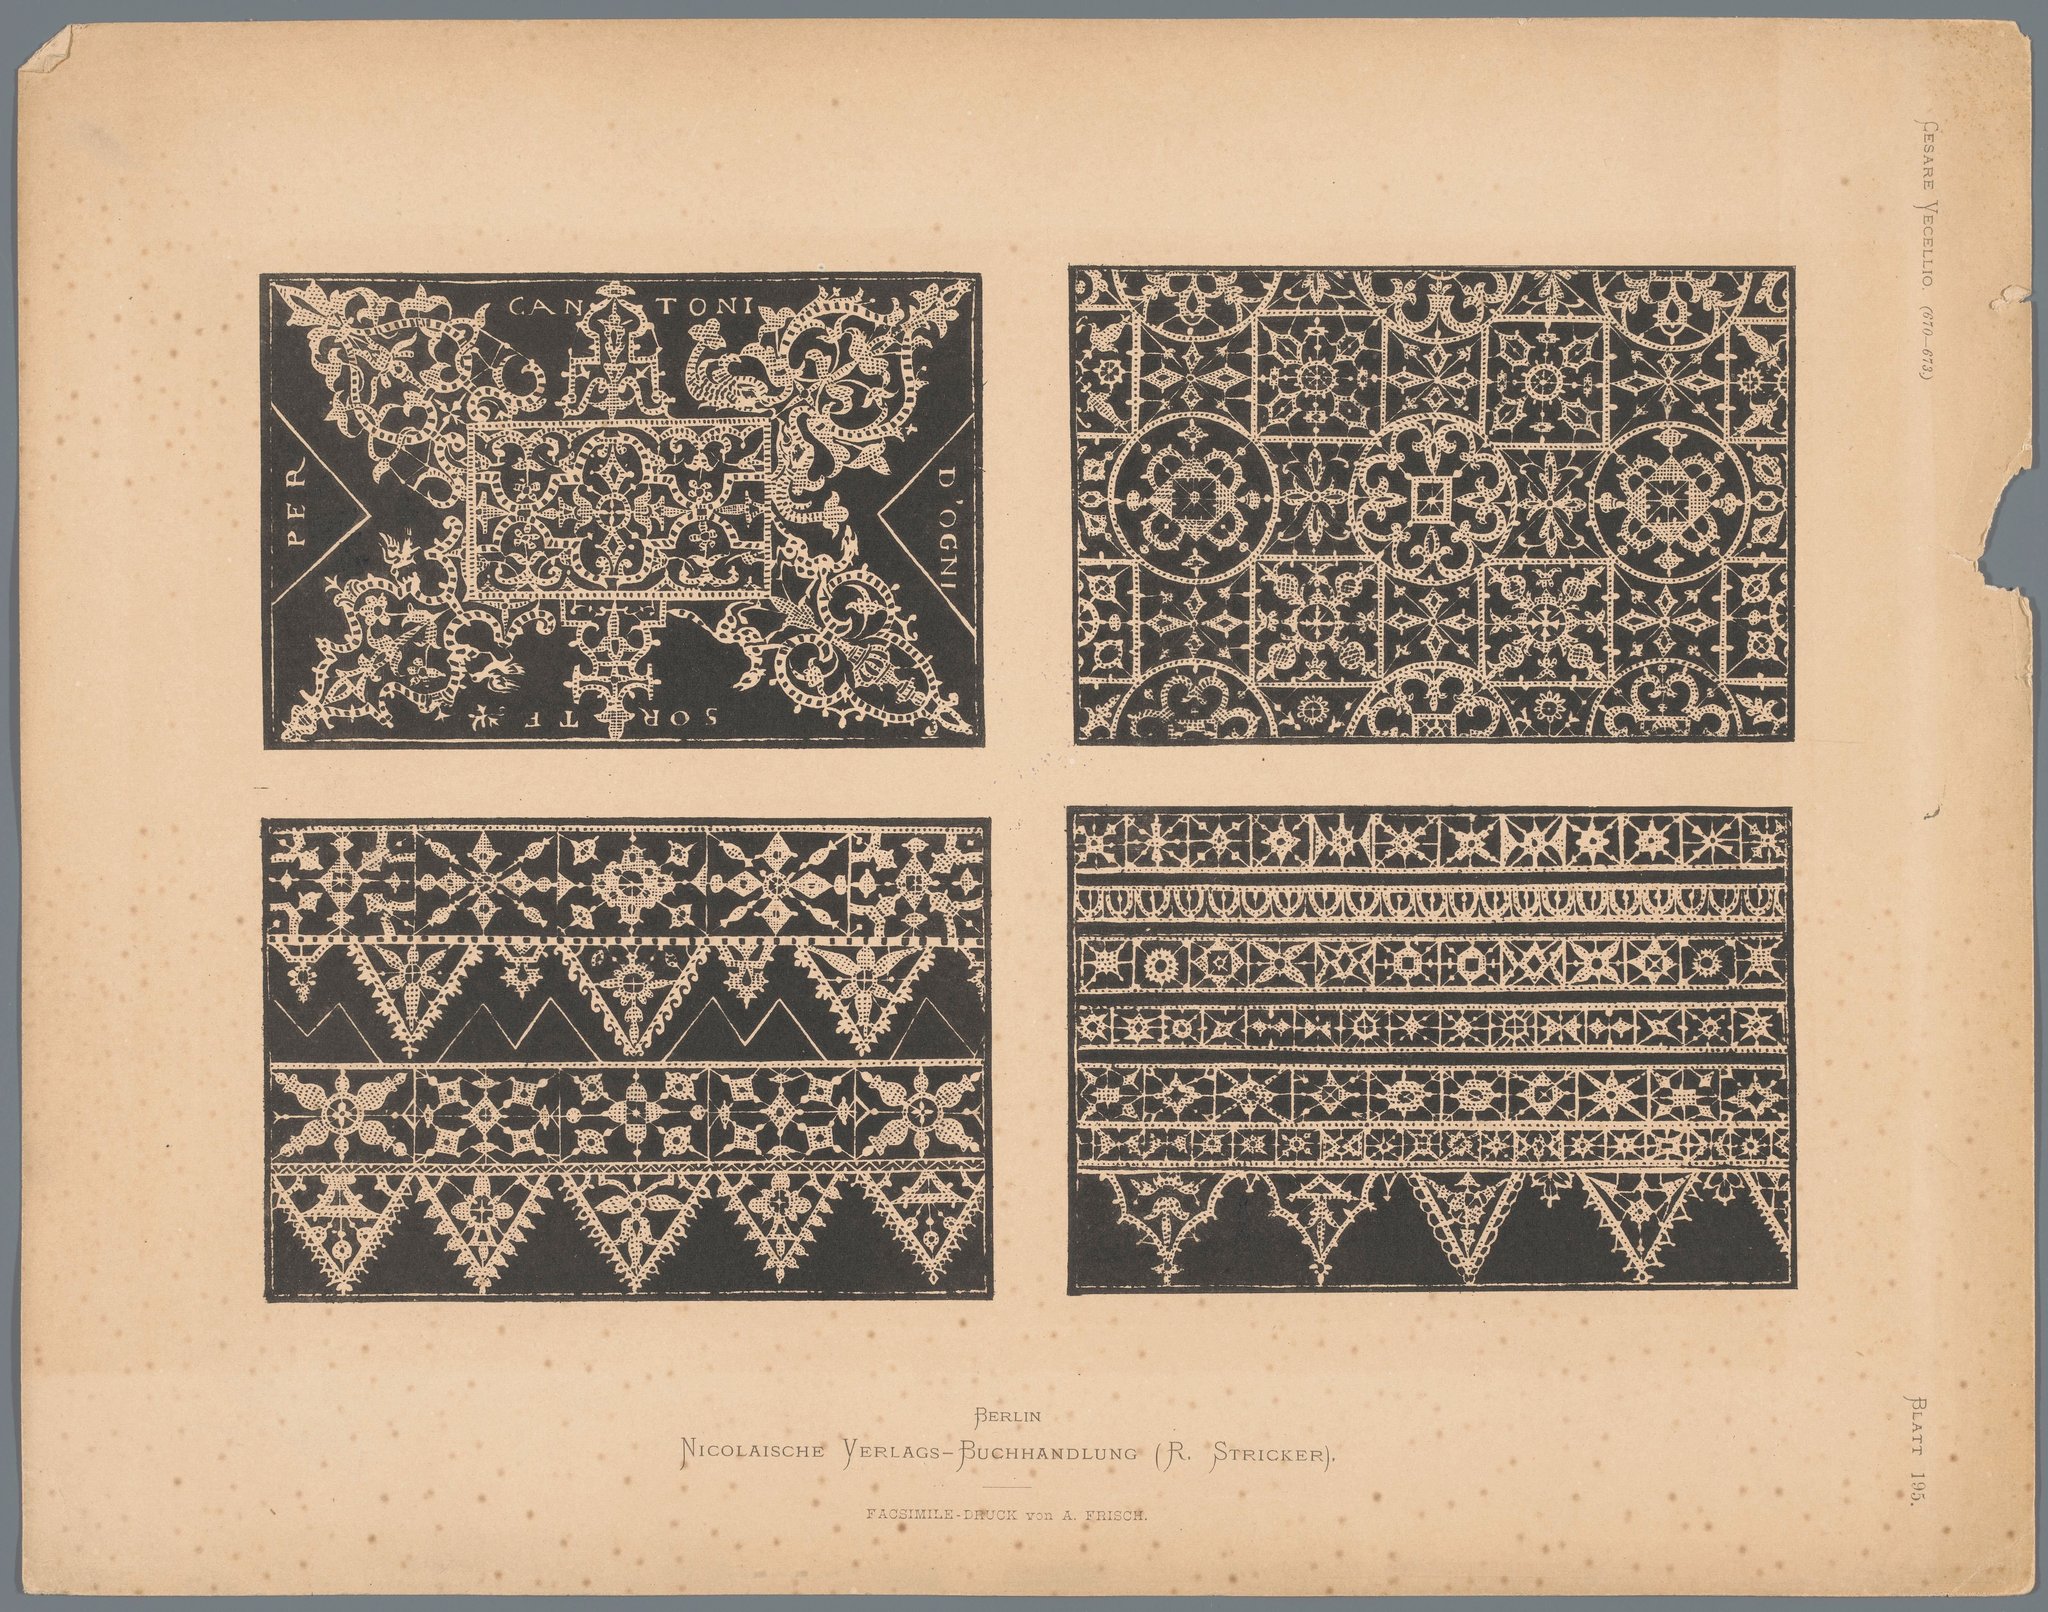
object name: photograph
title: Vier patronen voor kantwerk door Cesare Vecellio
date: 1875-1900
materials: paper, ink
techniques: photograph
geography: europe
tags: lace, europe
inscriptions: inscription: ‘Blatt 195’, collector's mark: Lugt 3937, name: ‘Cesare Vecellio (670-673)’